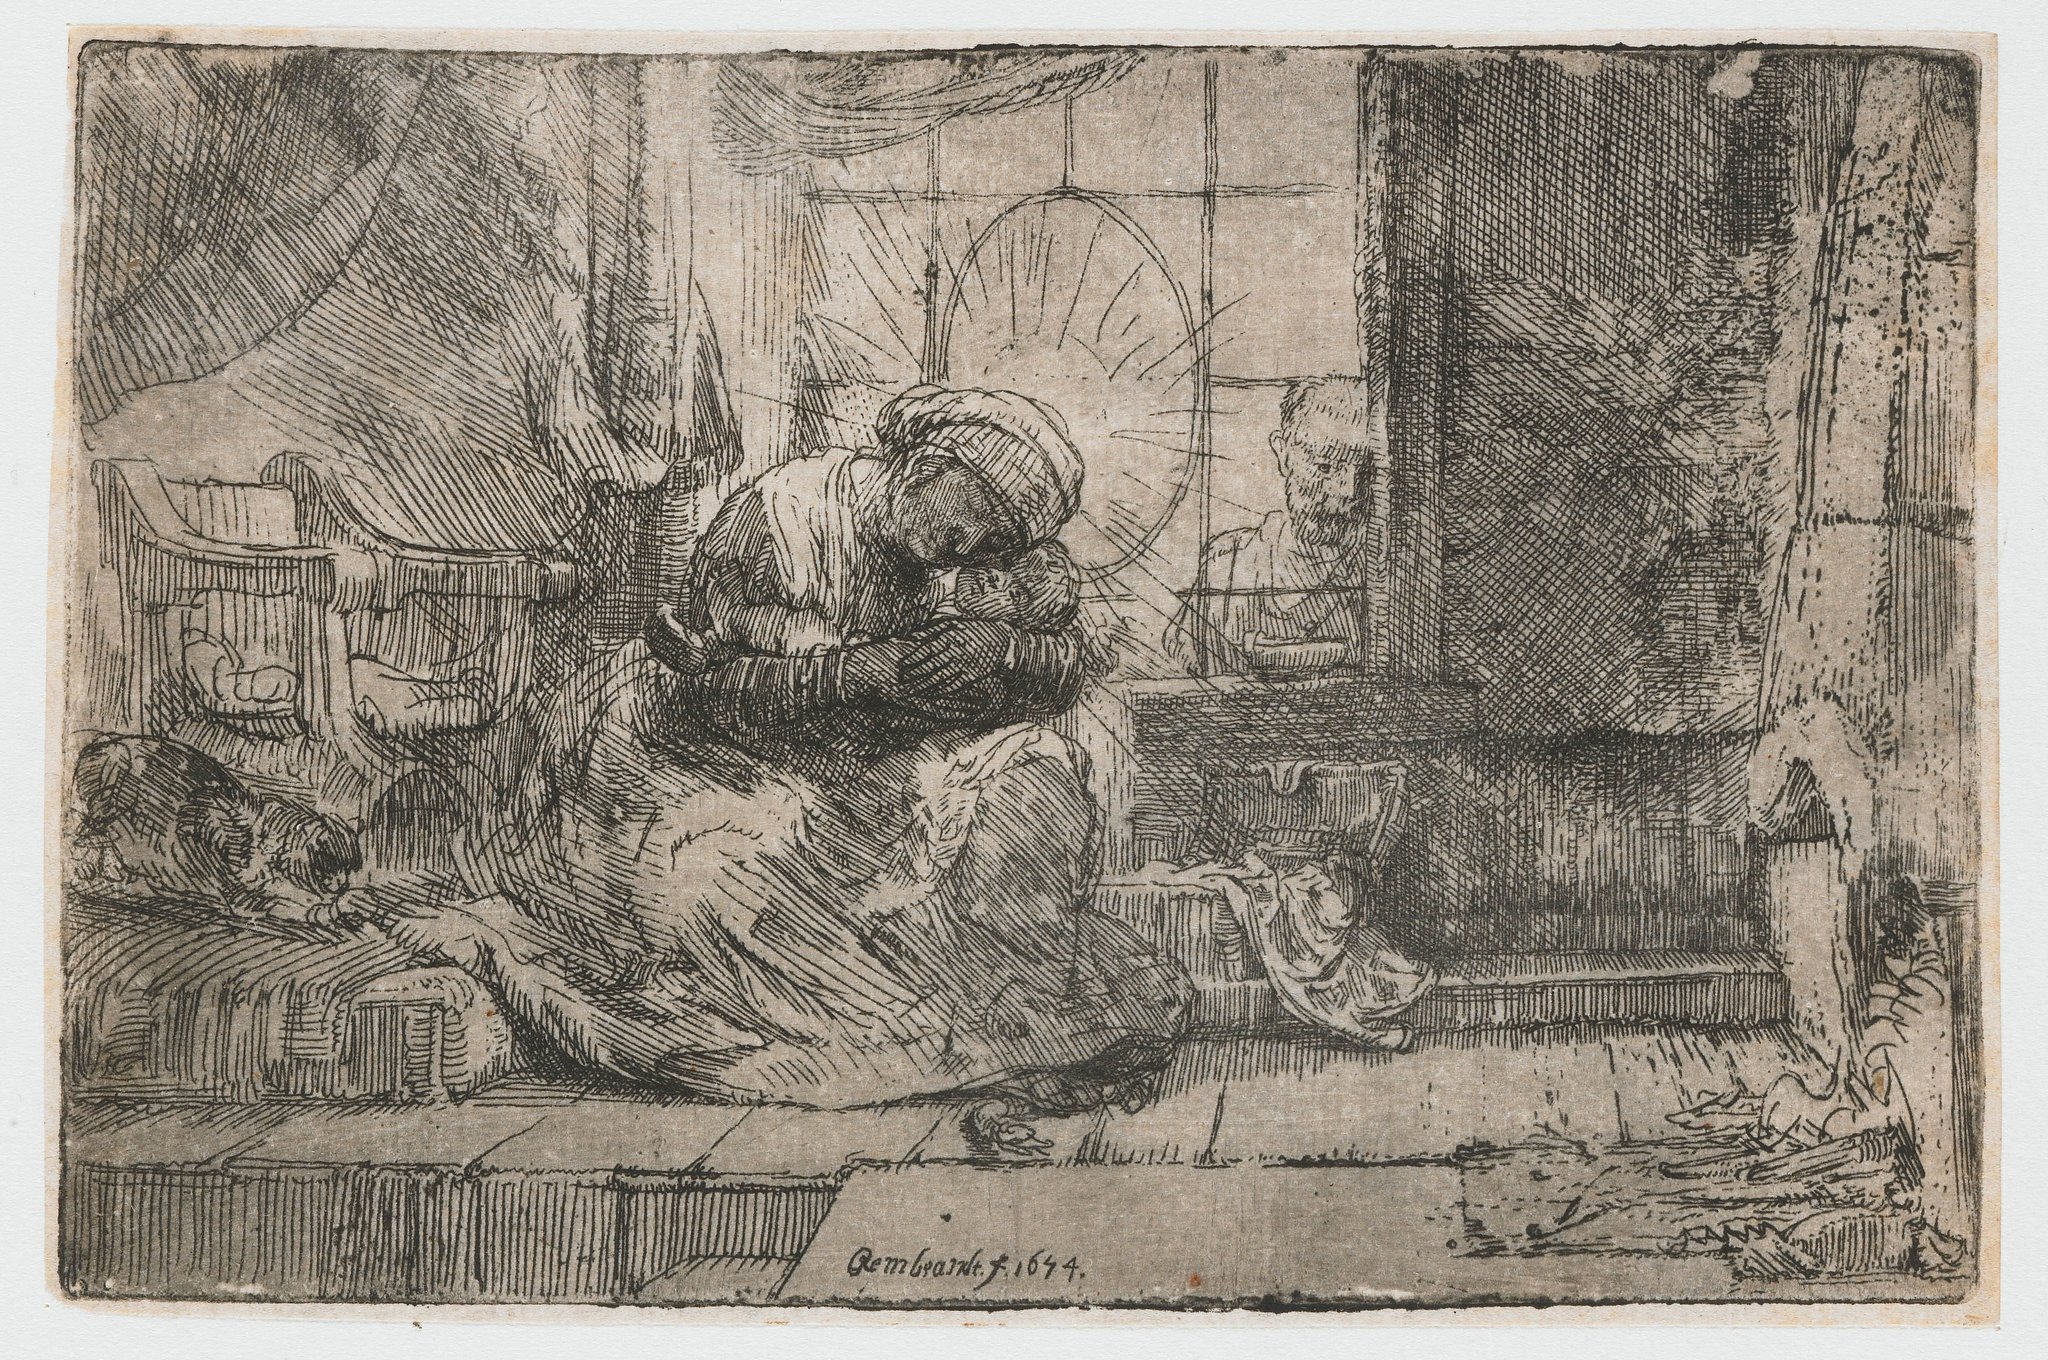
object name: print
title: The Virgin and Child with the Cat and the Snake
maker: rembrandt van rijn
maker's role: draughtsman, painter, print maker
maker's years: 1606-1669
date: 1654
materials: paper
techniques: etching, intaglio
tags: madonna: mary sitting on the ground, the christ-child in her lap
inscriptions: signature and date: ‘Rembrandt.f.1654’, mark: Lugt 2228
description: This intimate scene is less ordinary than it seems. Rembrandt etches the Virgin holding her child in her arms, apparently cosily seated near the window. However, the snake slithering out from under her skirt has no place in a domestic idyll. The Virgin treading on the snake is a theological allusion that was understood at the time as foreshadowing Christ’s triumph over Satan.